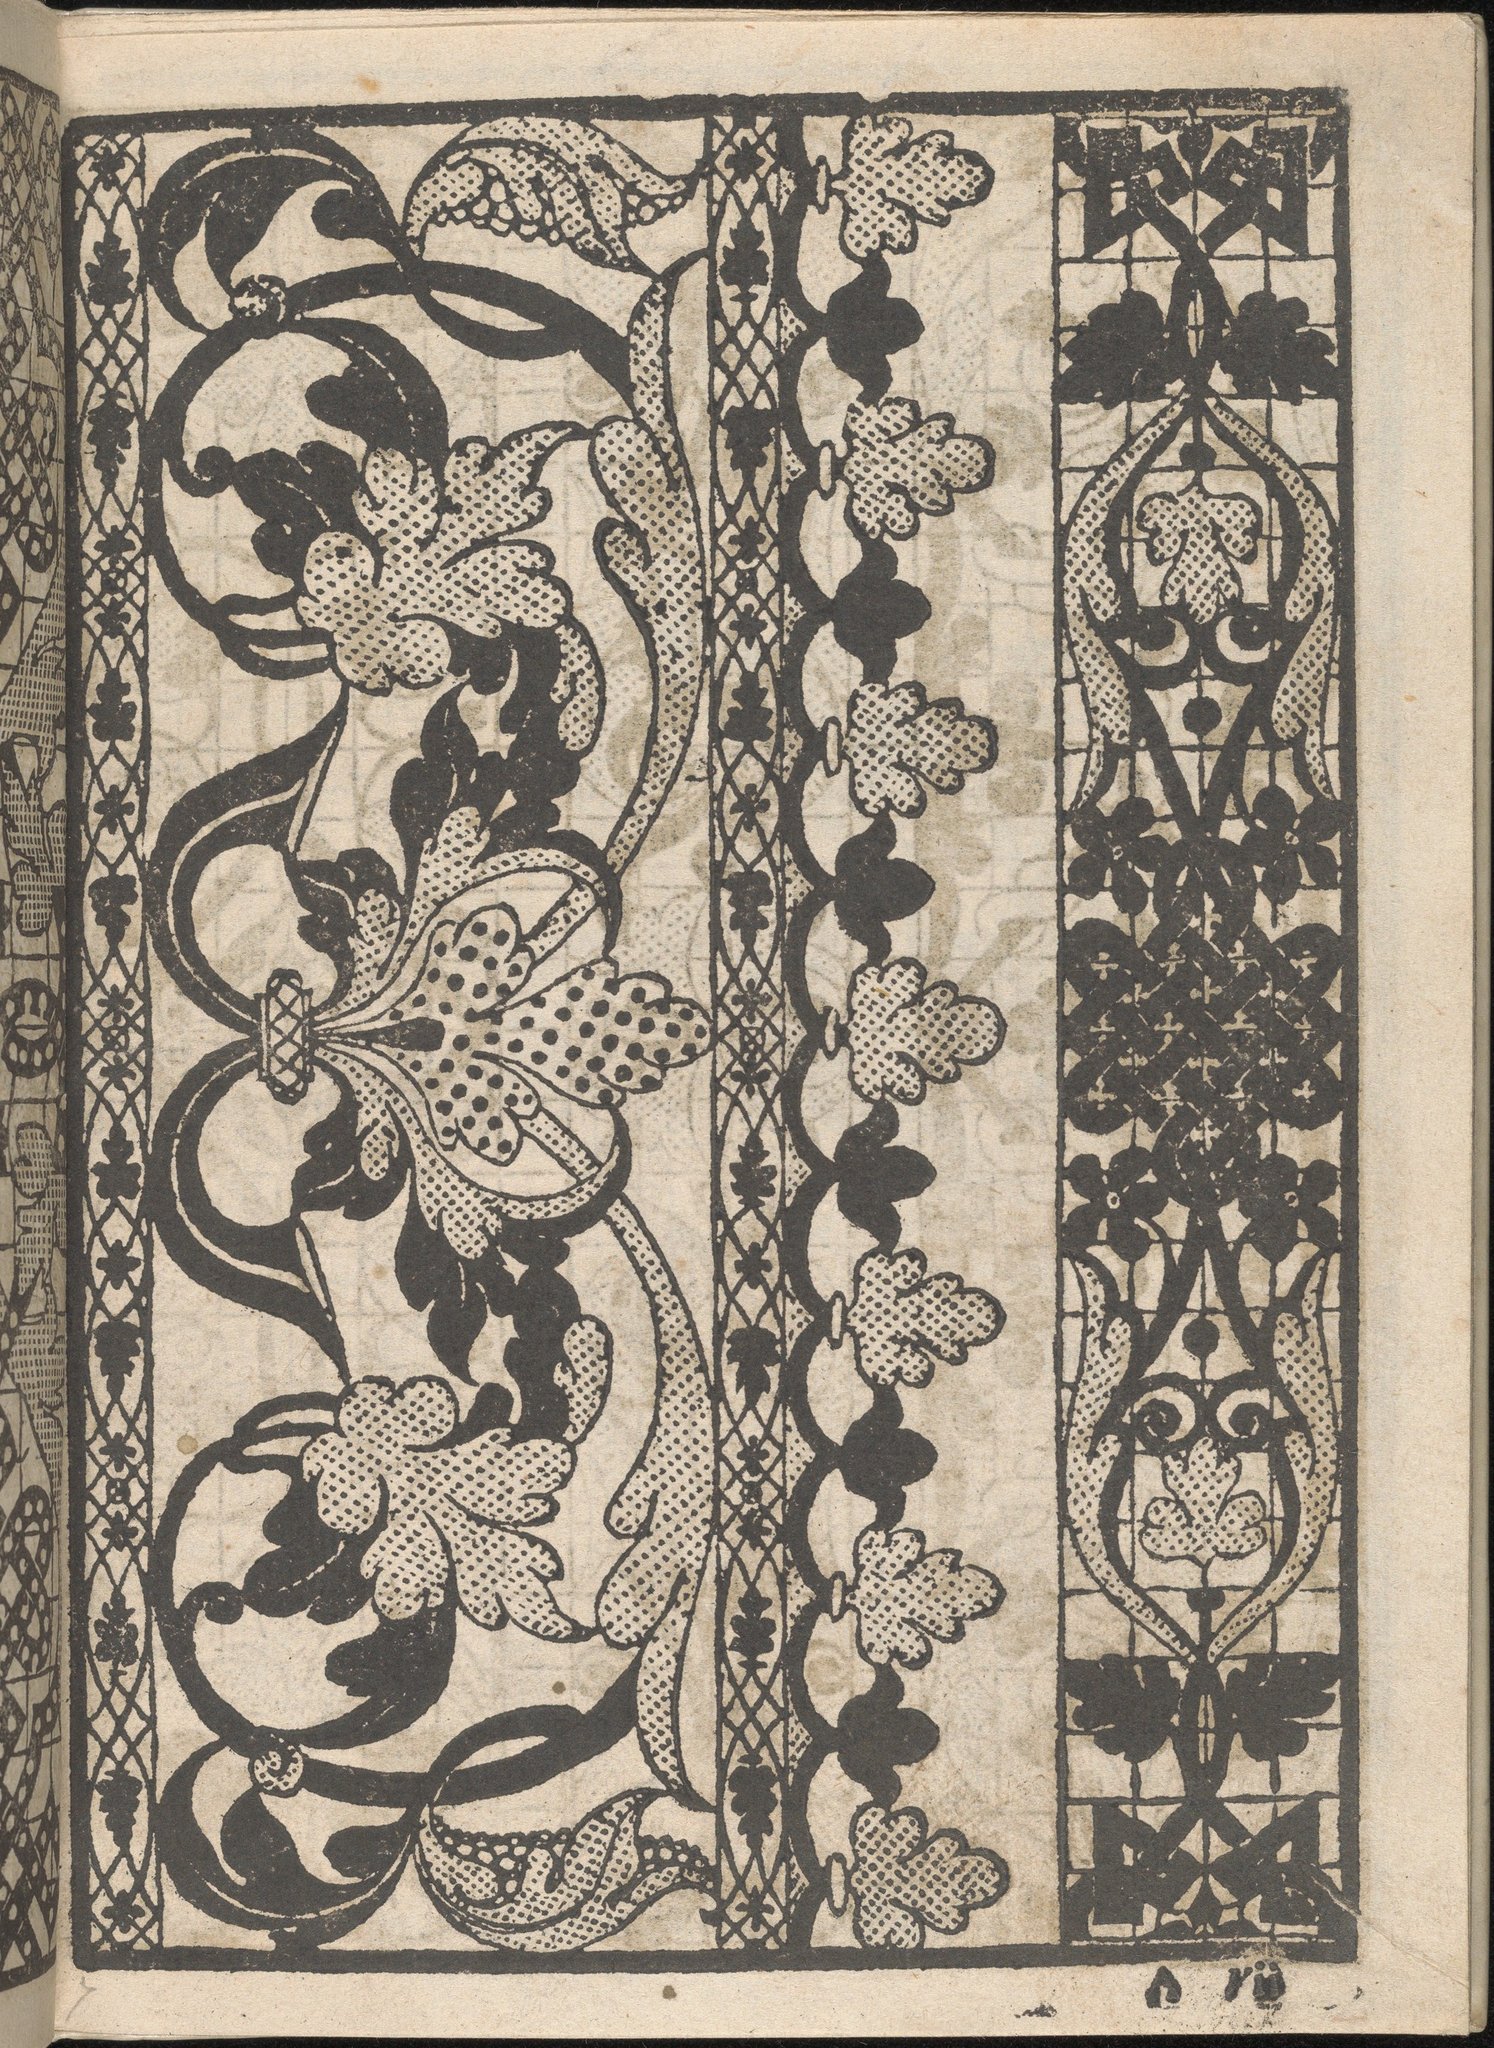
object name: book print ornament architecture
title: Splendore delle virtuose giovani, page 4 (recto)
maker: iseppo foresto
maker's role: designer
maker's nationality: italian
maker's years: 1520-1580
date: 1564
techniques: woodcut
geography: italy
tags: women,flowers